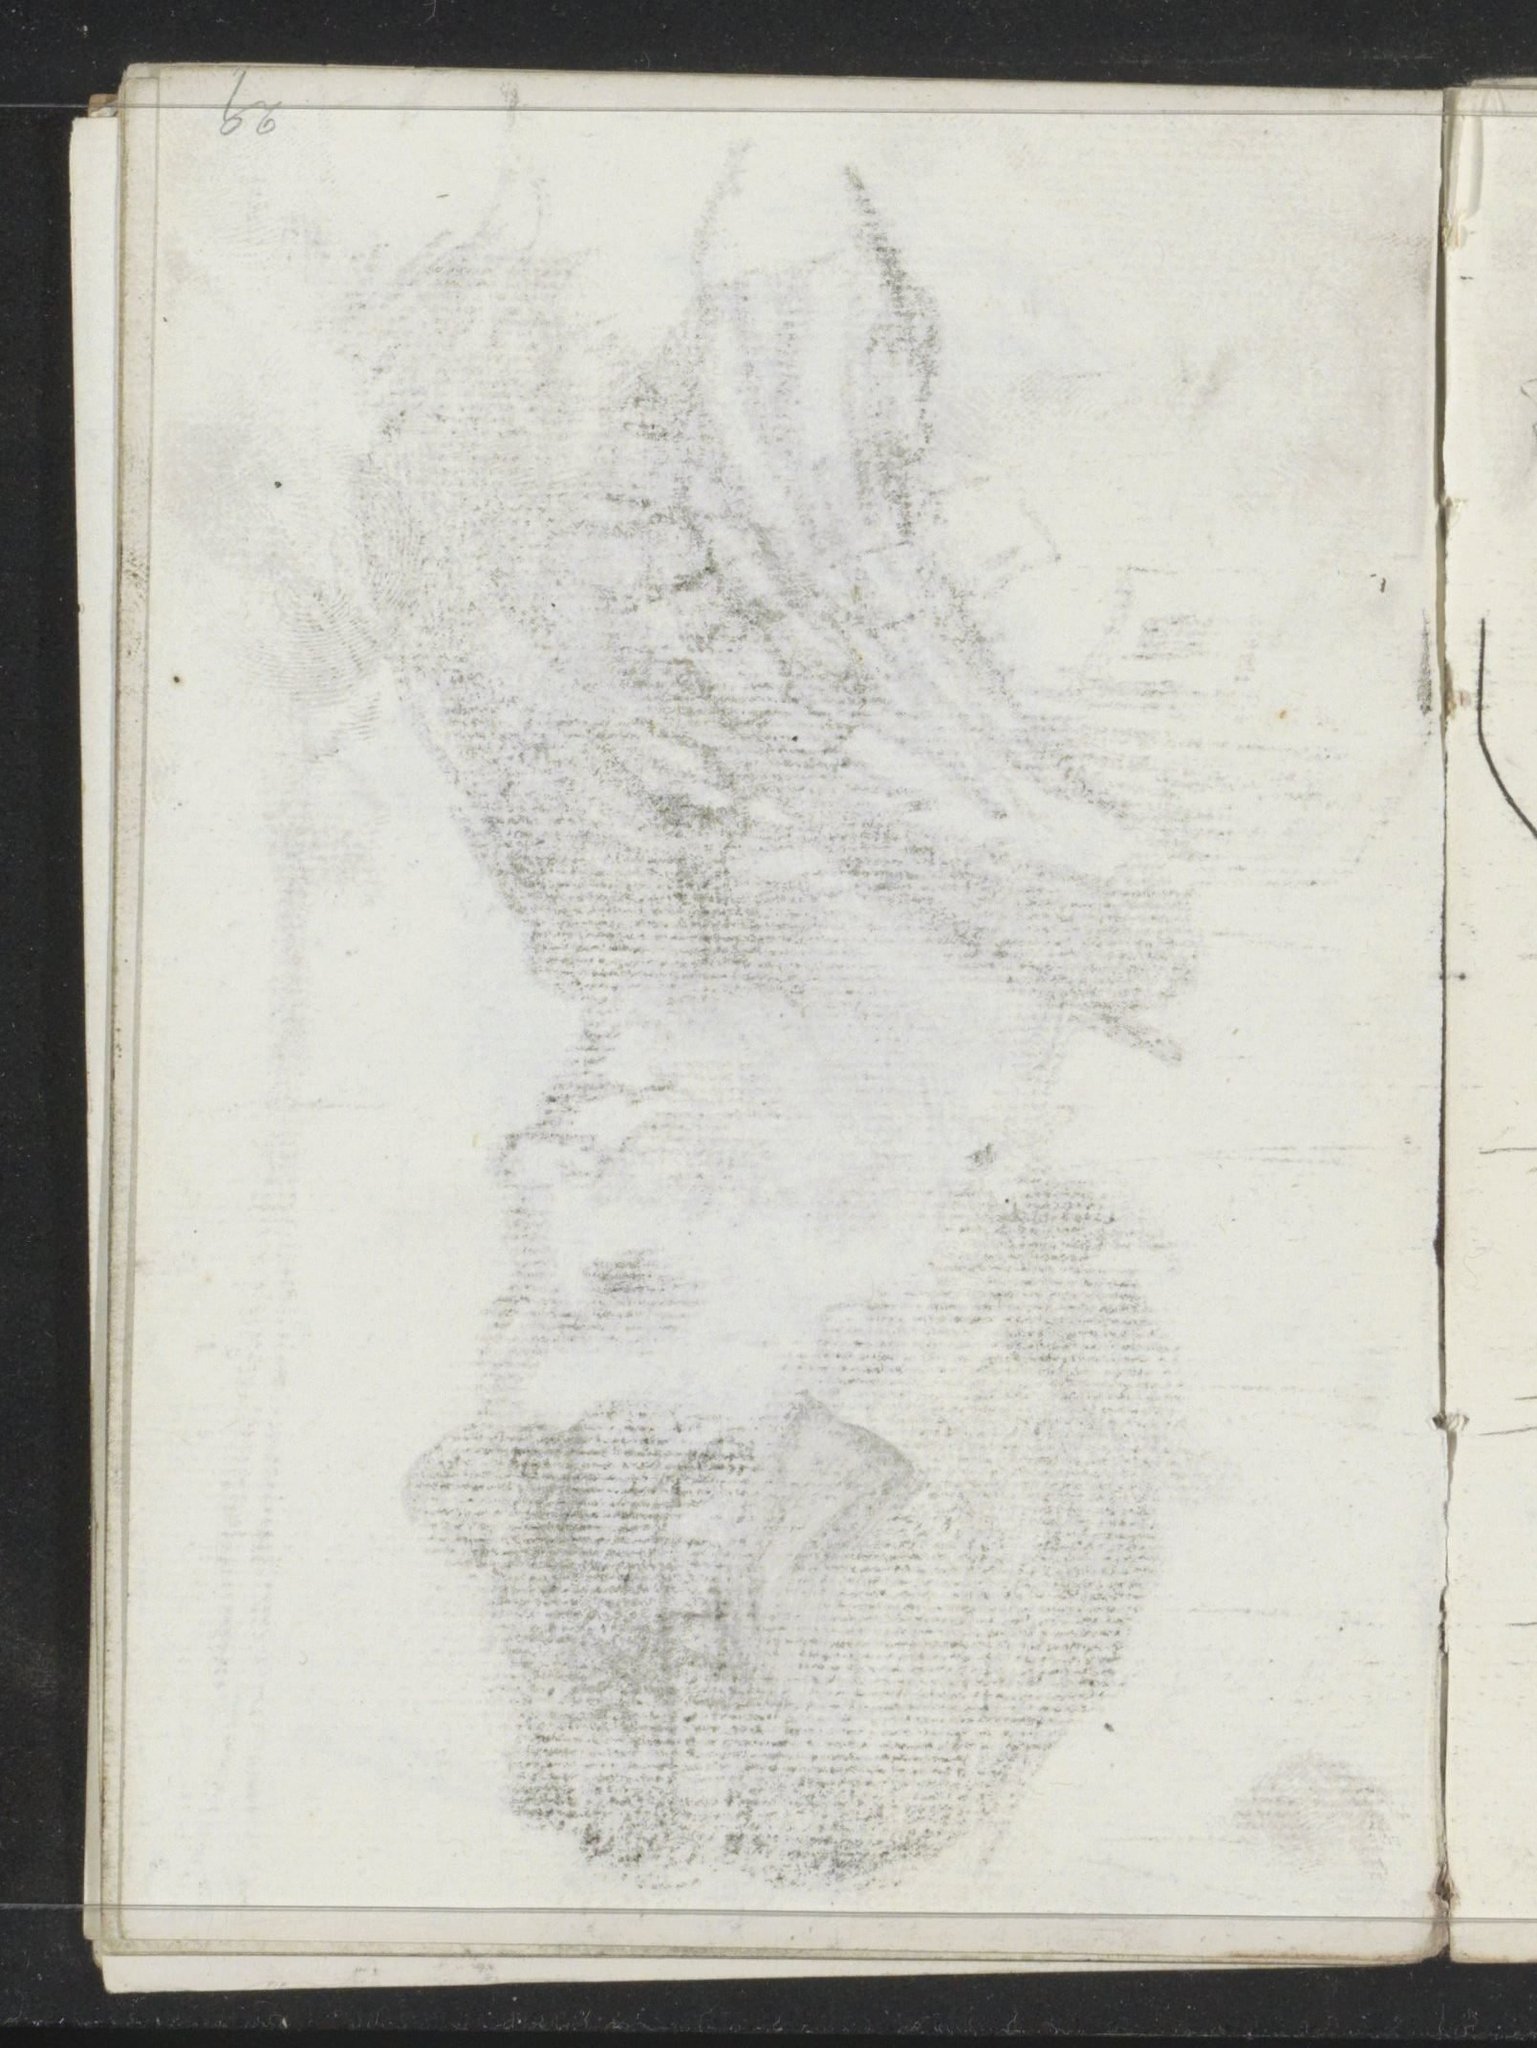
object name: sketchbook leaf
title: Abklatsch van de krijttekening op blad 9 recto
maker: isaac israels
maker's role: draughtsman, painter, print maker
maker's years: 1865-1934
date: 1886-1934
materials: paper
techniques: printmaking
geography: amsterdam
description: Blad 8 verso uit schetsboek LXIII met 23 bladen.